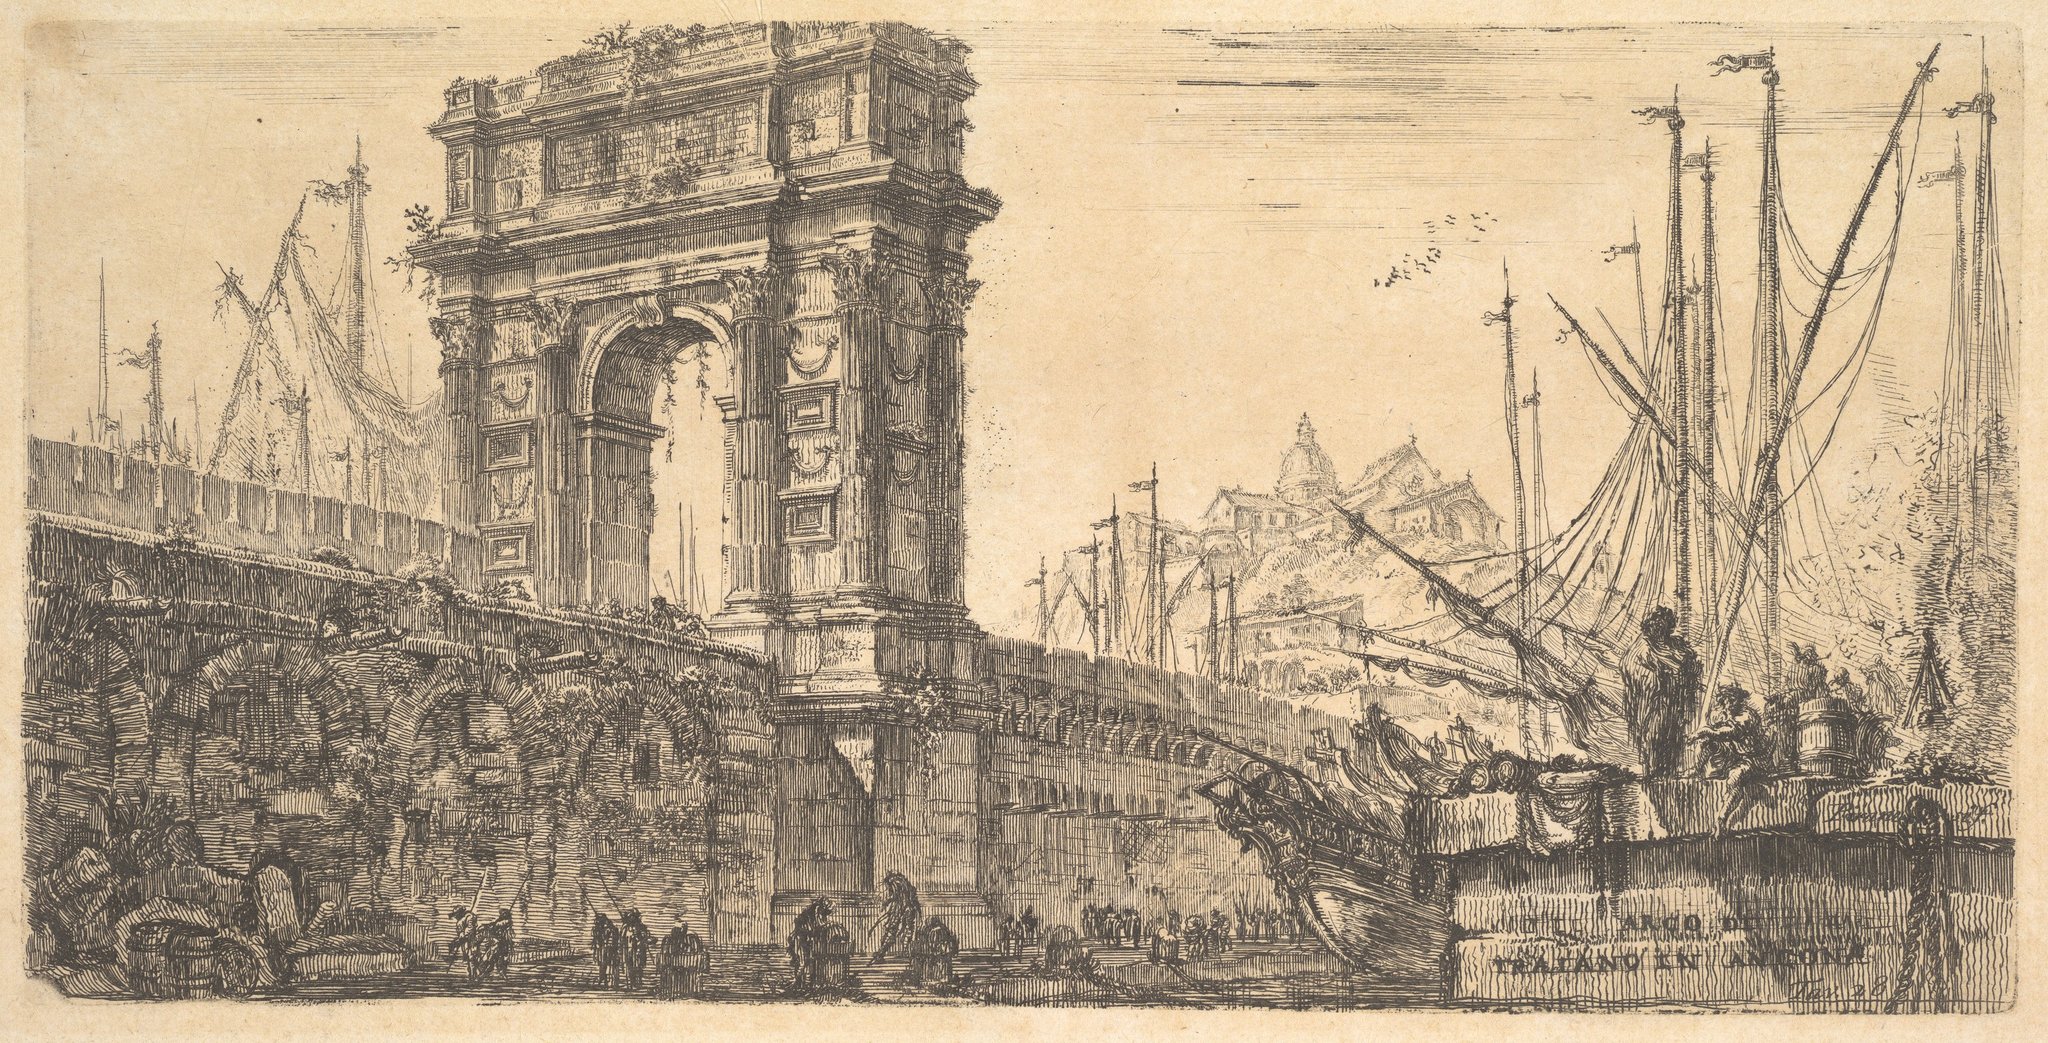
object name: print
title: Plate 28: Arch of Trajan in Ancona (Arco di Trajano in Ancona), from "Alcune Vedute di Archi Trionfali ed altri monumenti inalzati da Romani parte di quali se veggono in Roma e parte per l'Italia" (Some Views of Triumphal Arches and other monuments erected by the Romans, some of which are in Rome and some elsewhere in Italy)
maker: giovanni battista piranesi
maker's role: artist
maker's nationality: italian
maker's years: 1720-1778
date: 1748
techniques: etching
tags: arches,ships